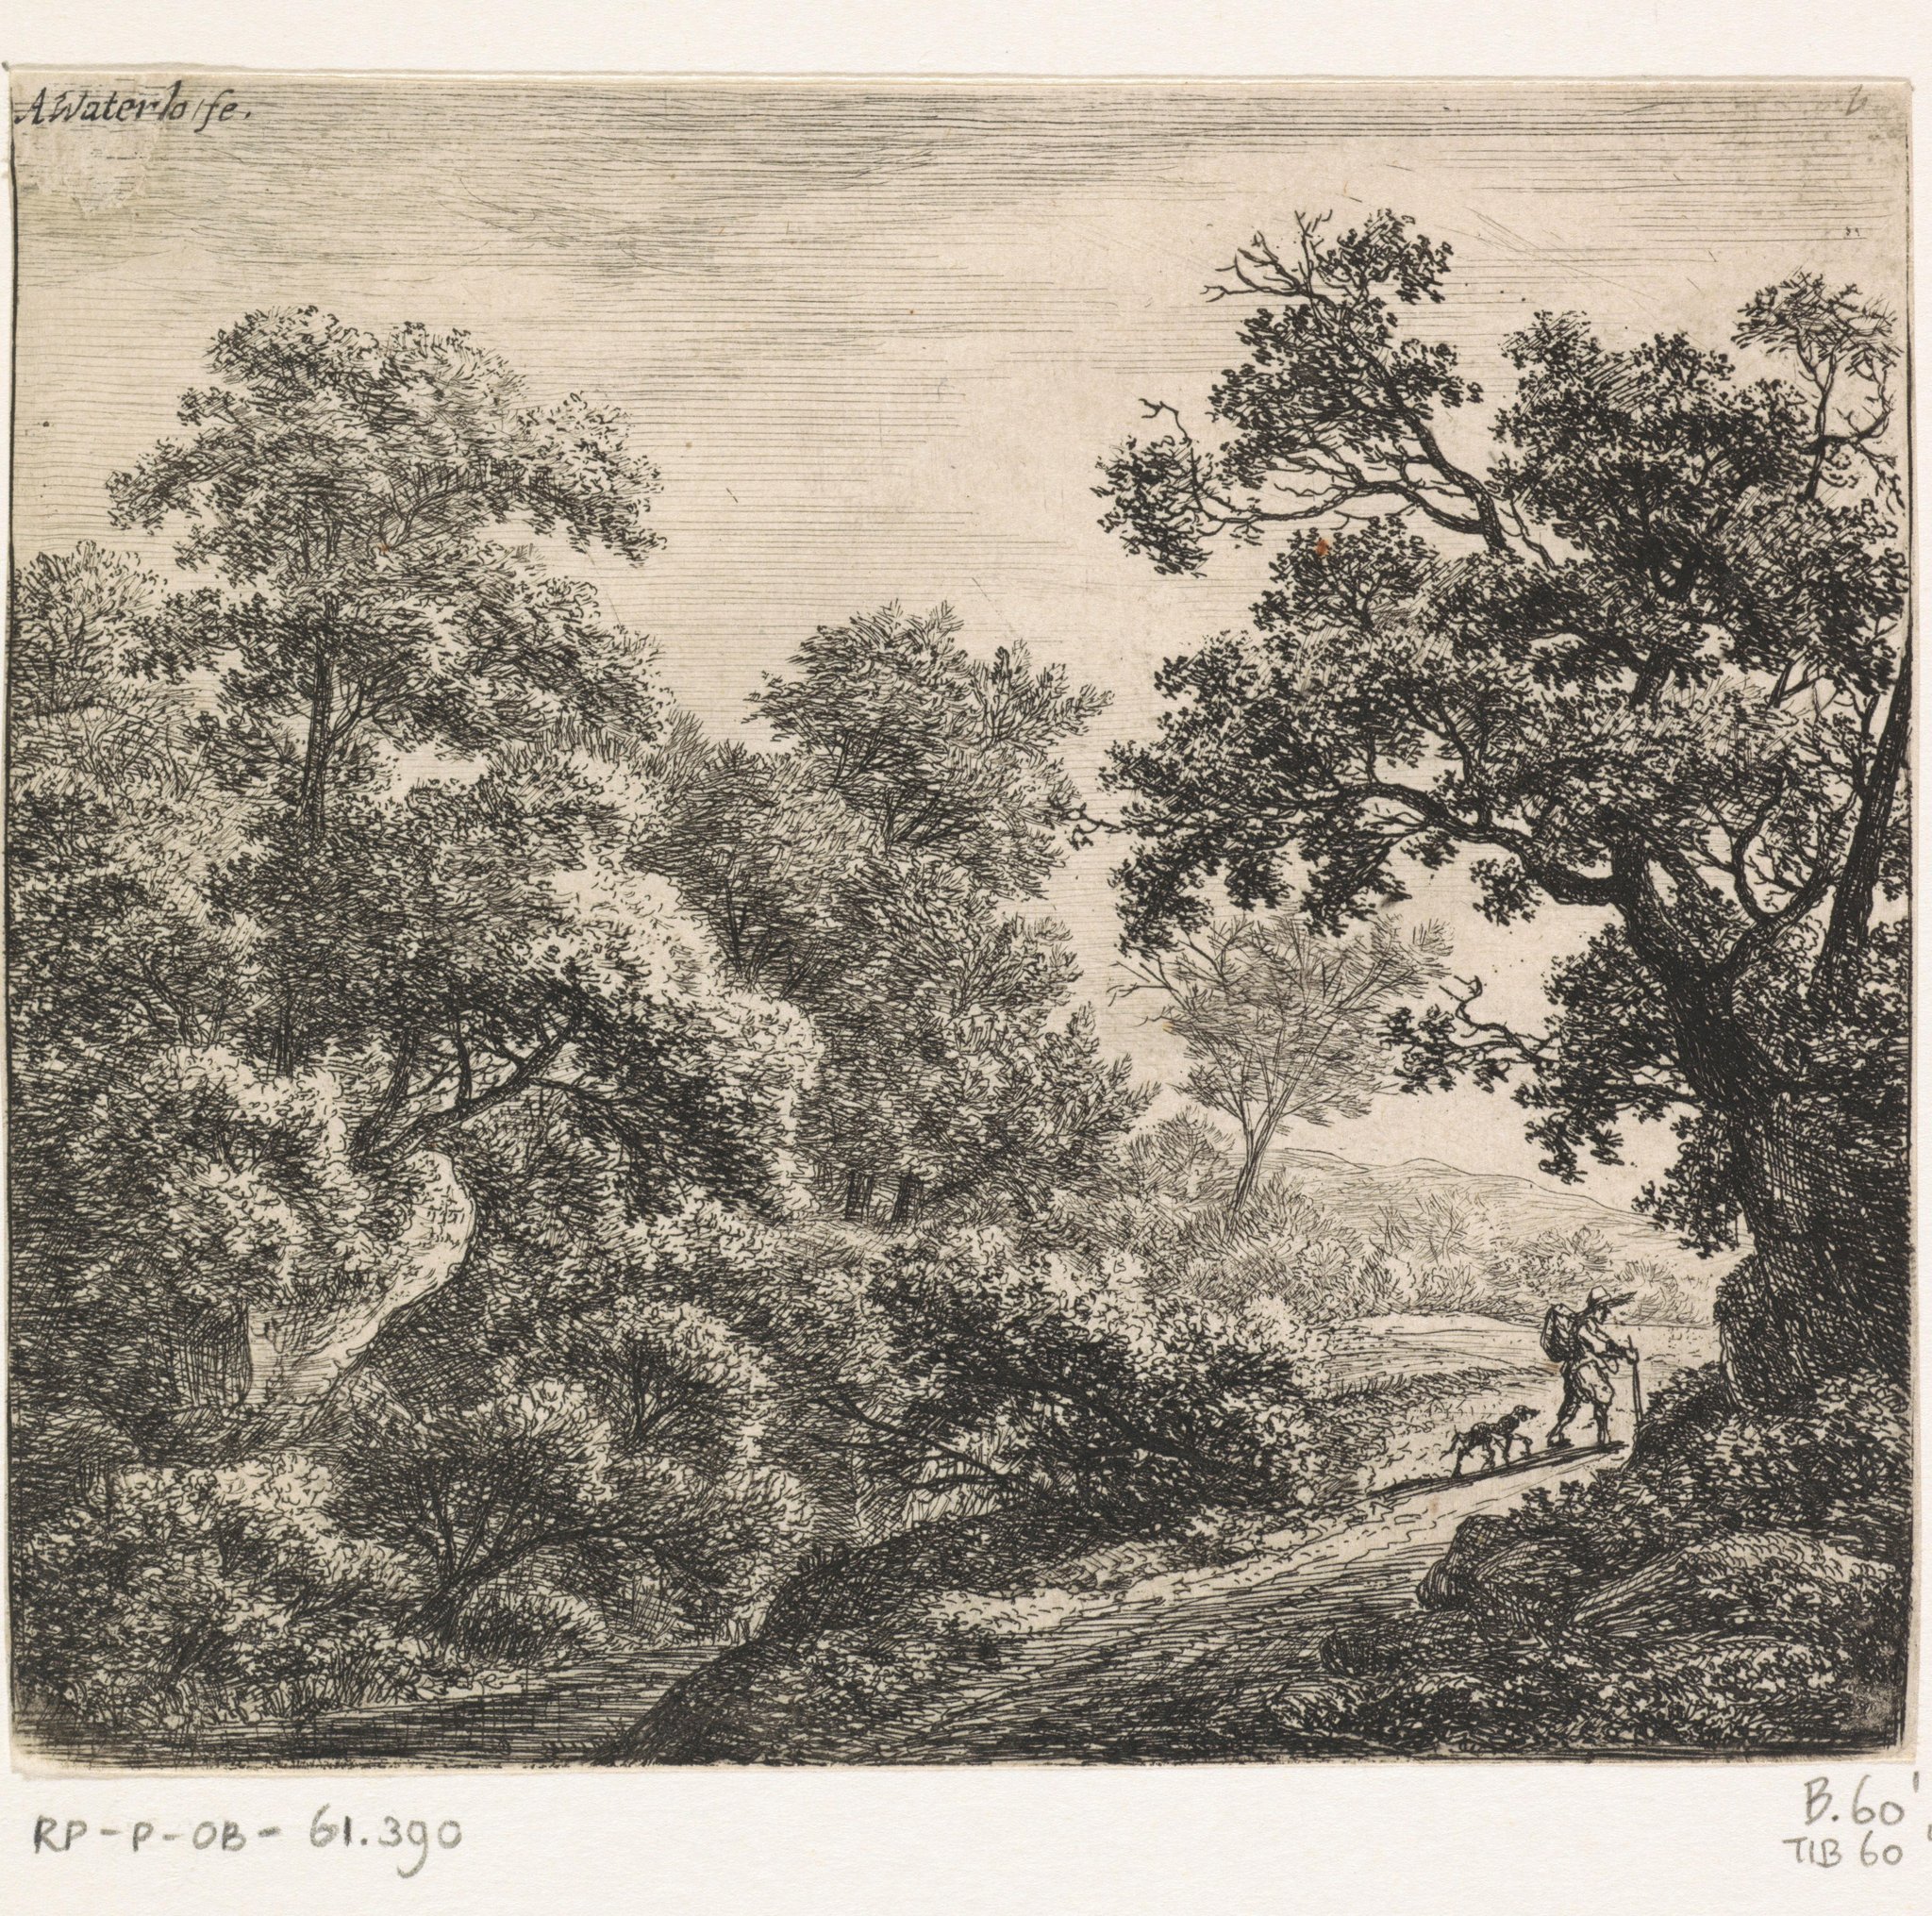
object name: print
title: Beboste landschappen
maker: anthonie waterloo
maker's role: draughtsman, painter, print maker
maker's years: 1609-1690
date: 1630-1663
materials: paper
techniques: etching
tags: forest, wood, brook, 'en route', traveller under way, dog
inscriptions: collector's mark: Lugt 240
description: In een heuvelachtig, bebost landschap loopt rechts een reiziger met een hond. Links stroomt een beek. Rechtsboven is de letter b te zien.